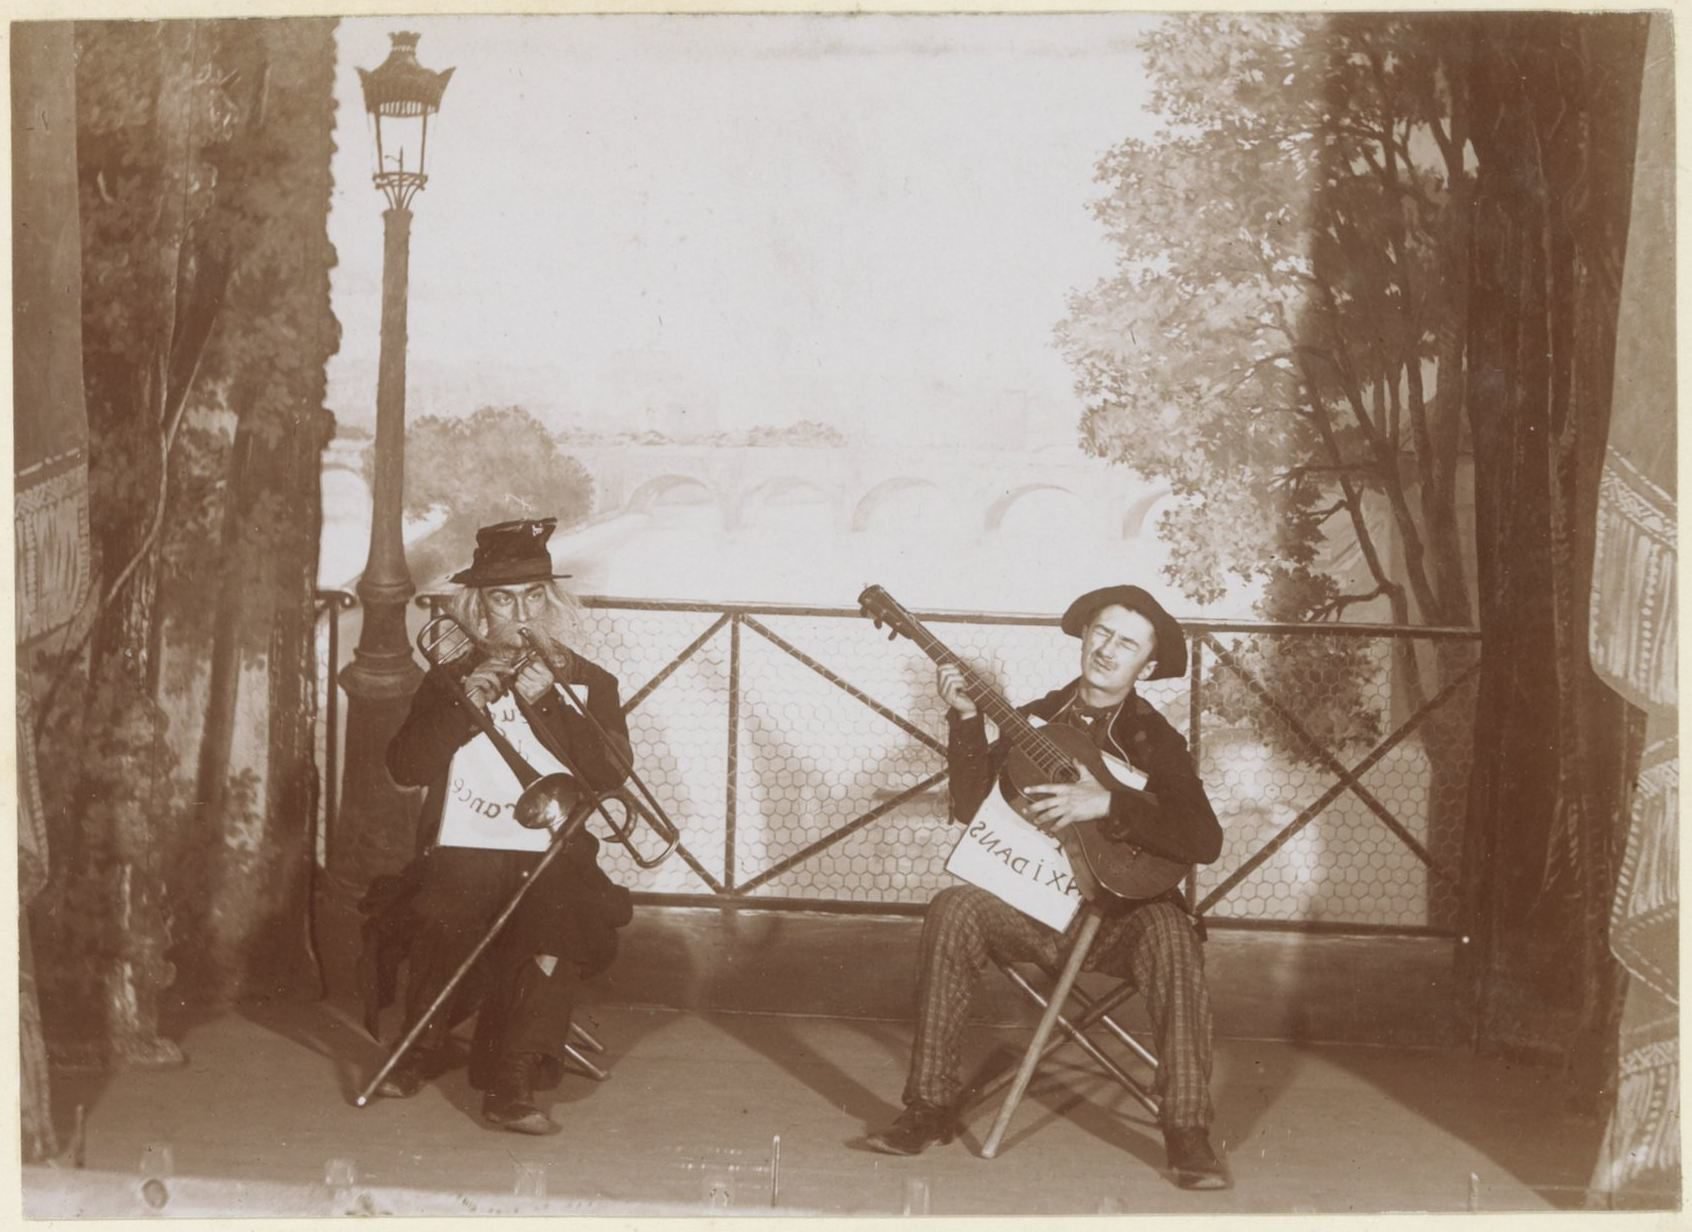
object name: photograph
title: Twee muzikanten op een toneel, vermoedelijk Franse amateurtoneelspelers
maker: Anonymous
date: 1900-1910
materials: paper, photographic support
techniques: daylight paper print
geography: france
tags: set, scenery ~ stage, theatre, theatrical performance, historical costume, wind instruments, string instruments (plucked), france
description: Onderdeel van Fotoalbum van een Franse amateurfotograaf met opnames van een familie, distilleerderij Delizy & Doistau Fils, het leger en bezienswaardigheden in Frankrijk.